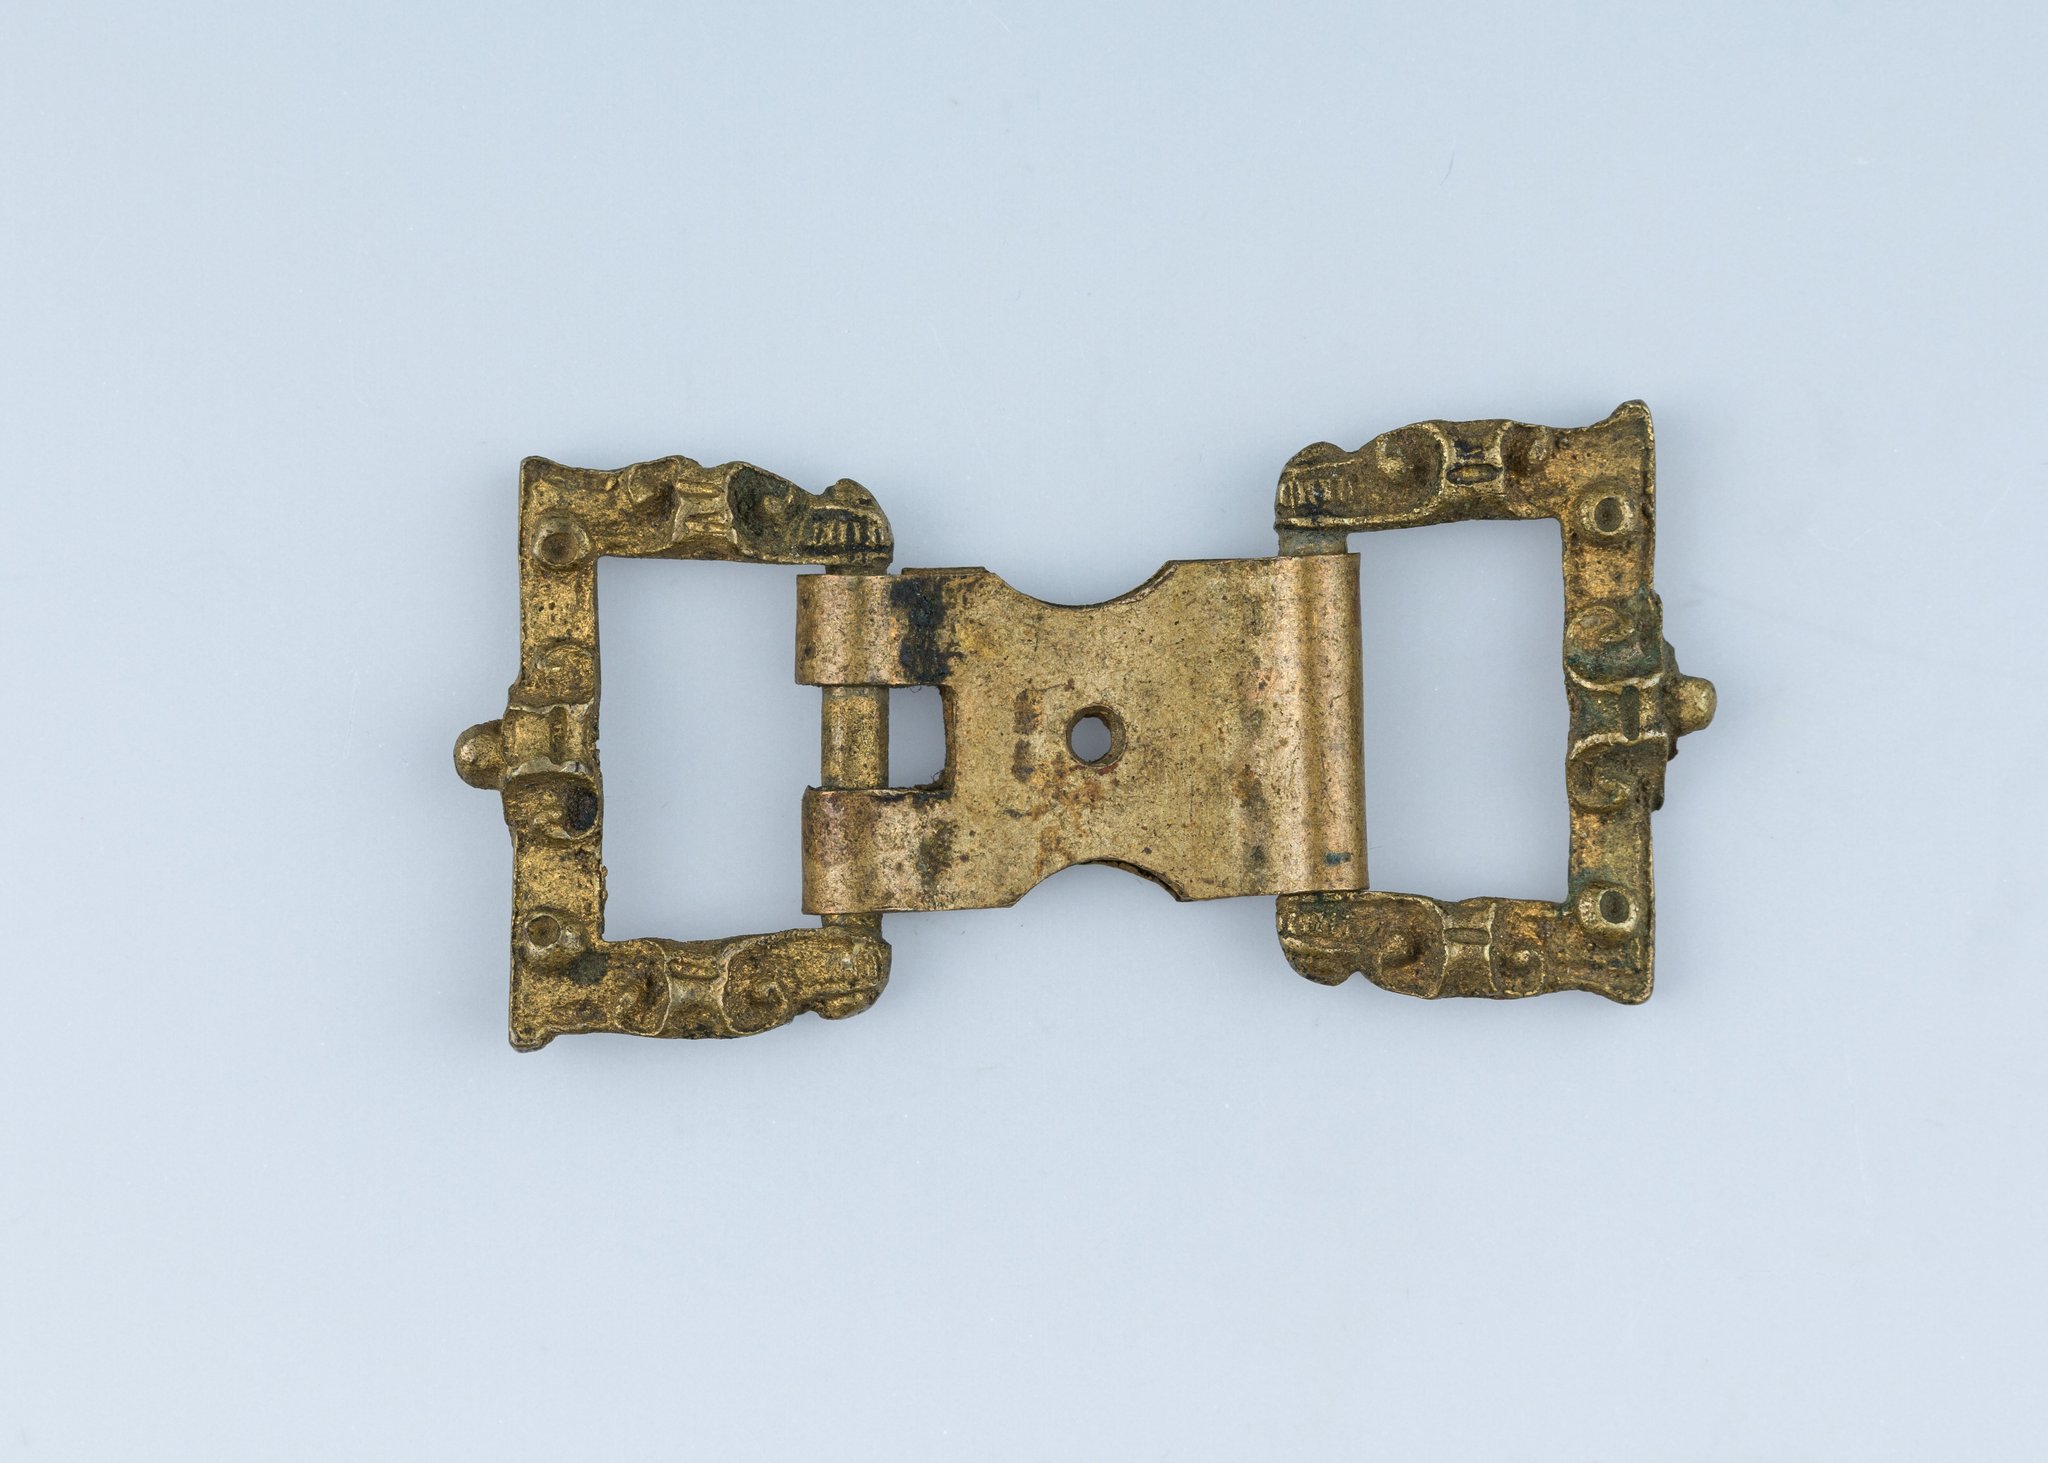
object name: buckle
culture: italian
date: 1550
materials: brass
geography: italy